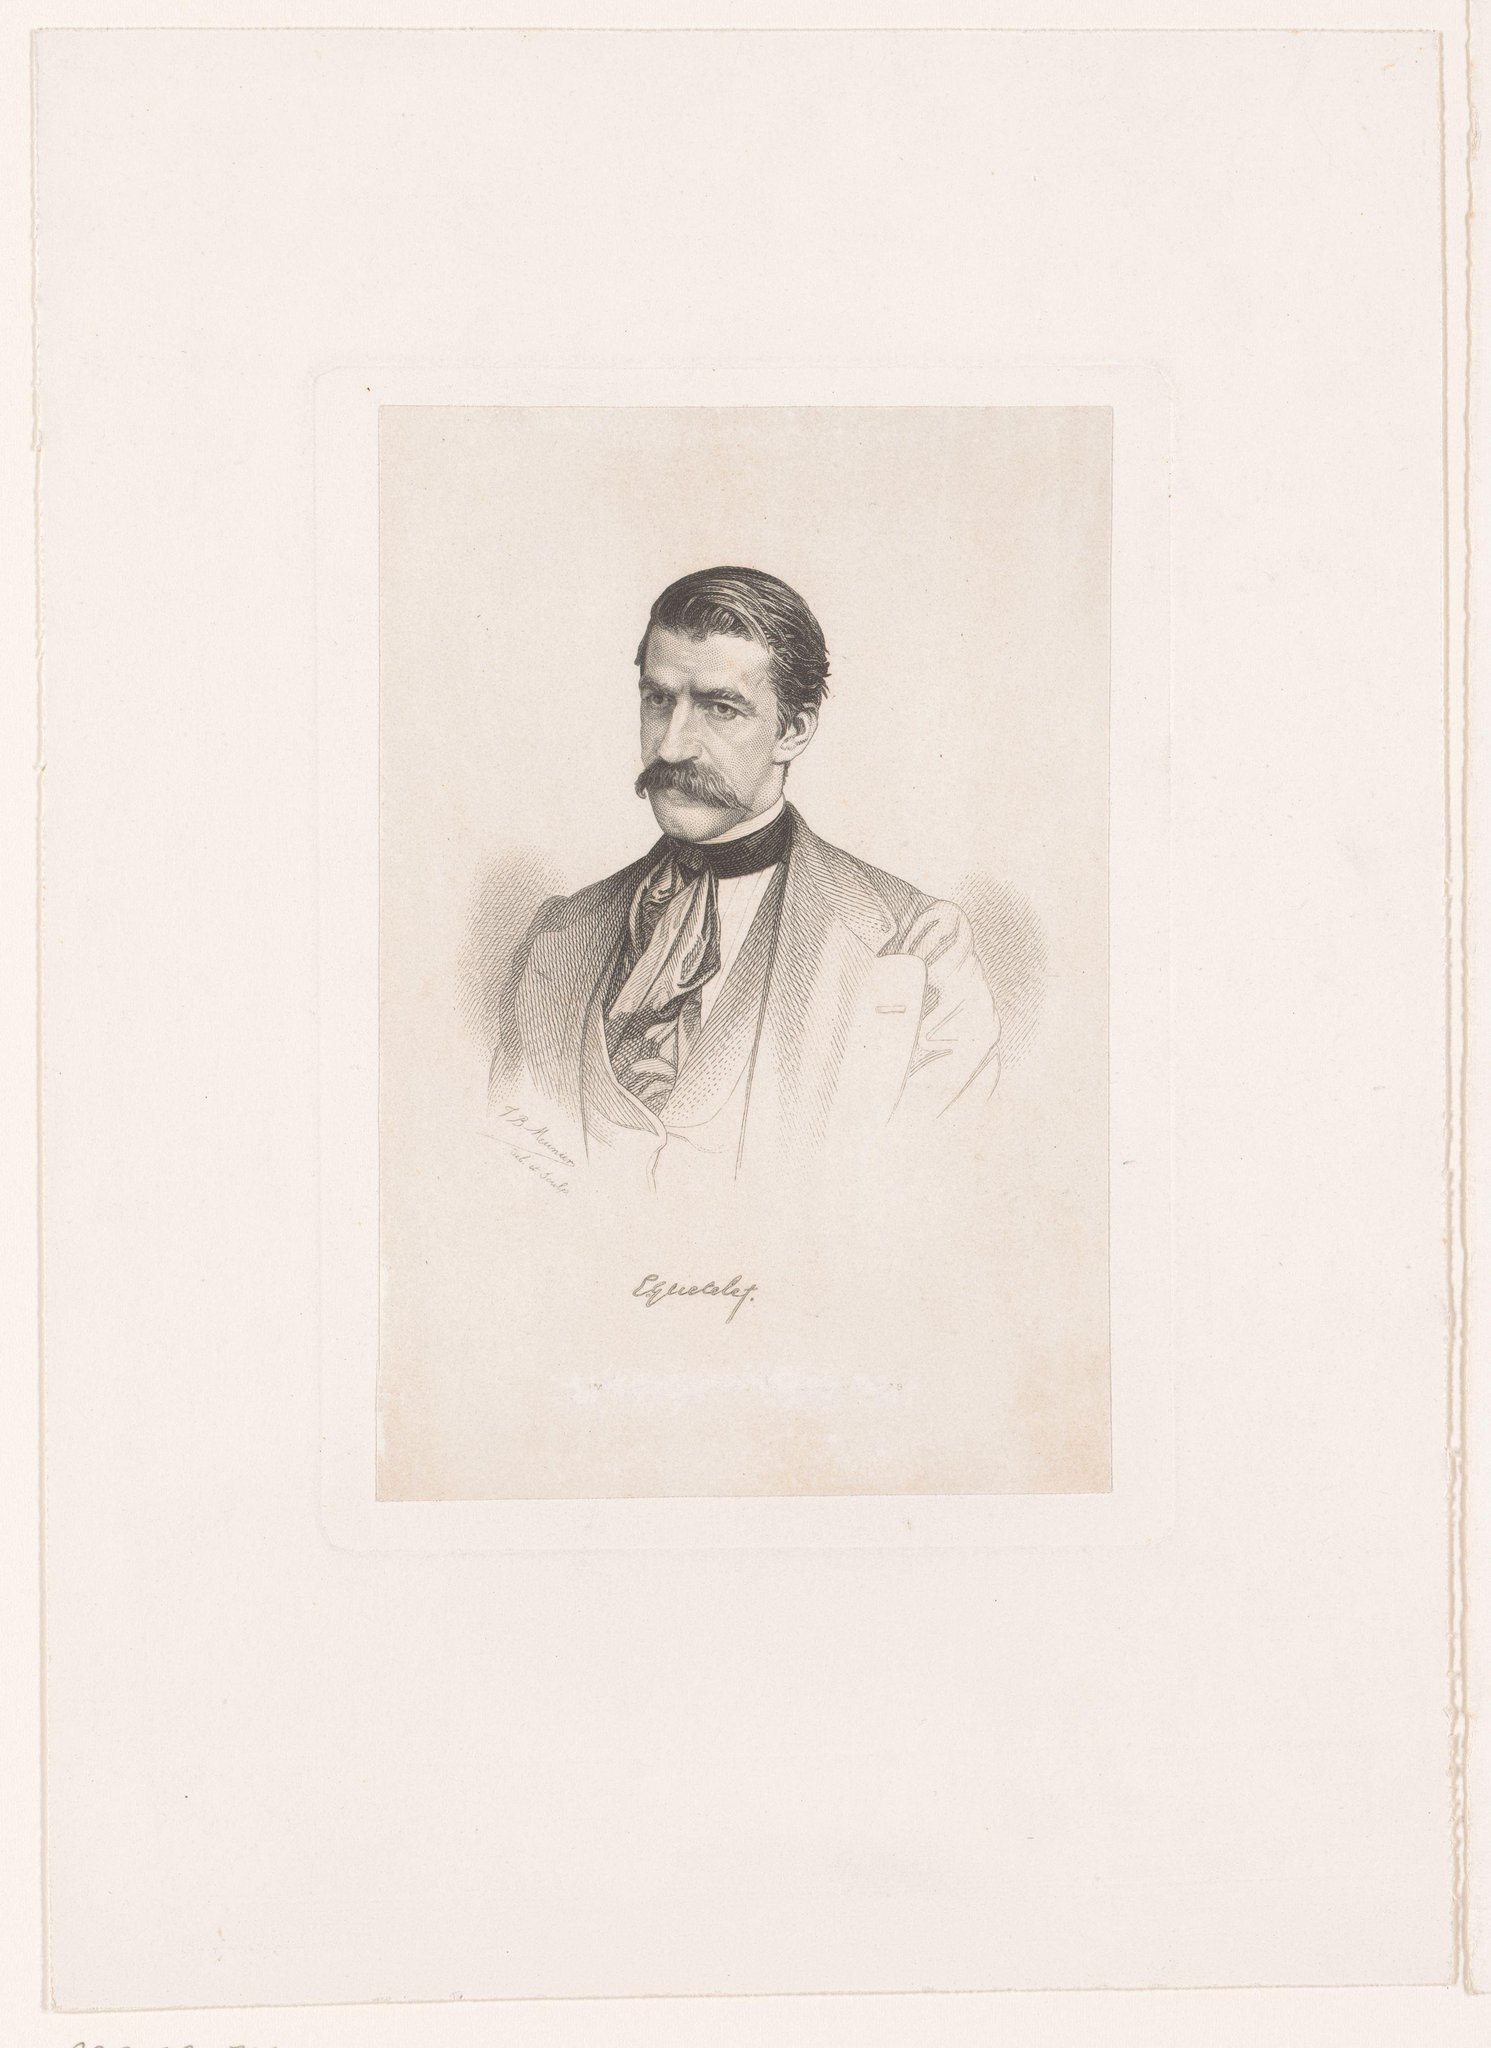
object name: print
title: E.Quetelet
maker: jean-baptiste meunier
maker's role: print maker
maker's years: 1821-1900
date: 1831-1900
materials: paper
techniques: etching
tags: moustache, adult man, historical persons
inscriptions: collector's mark: Lugt 2228